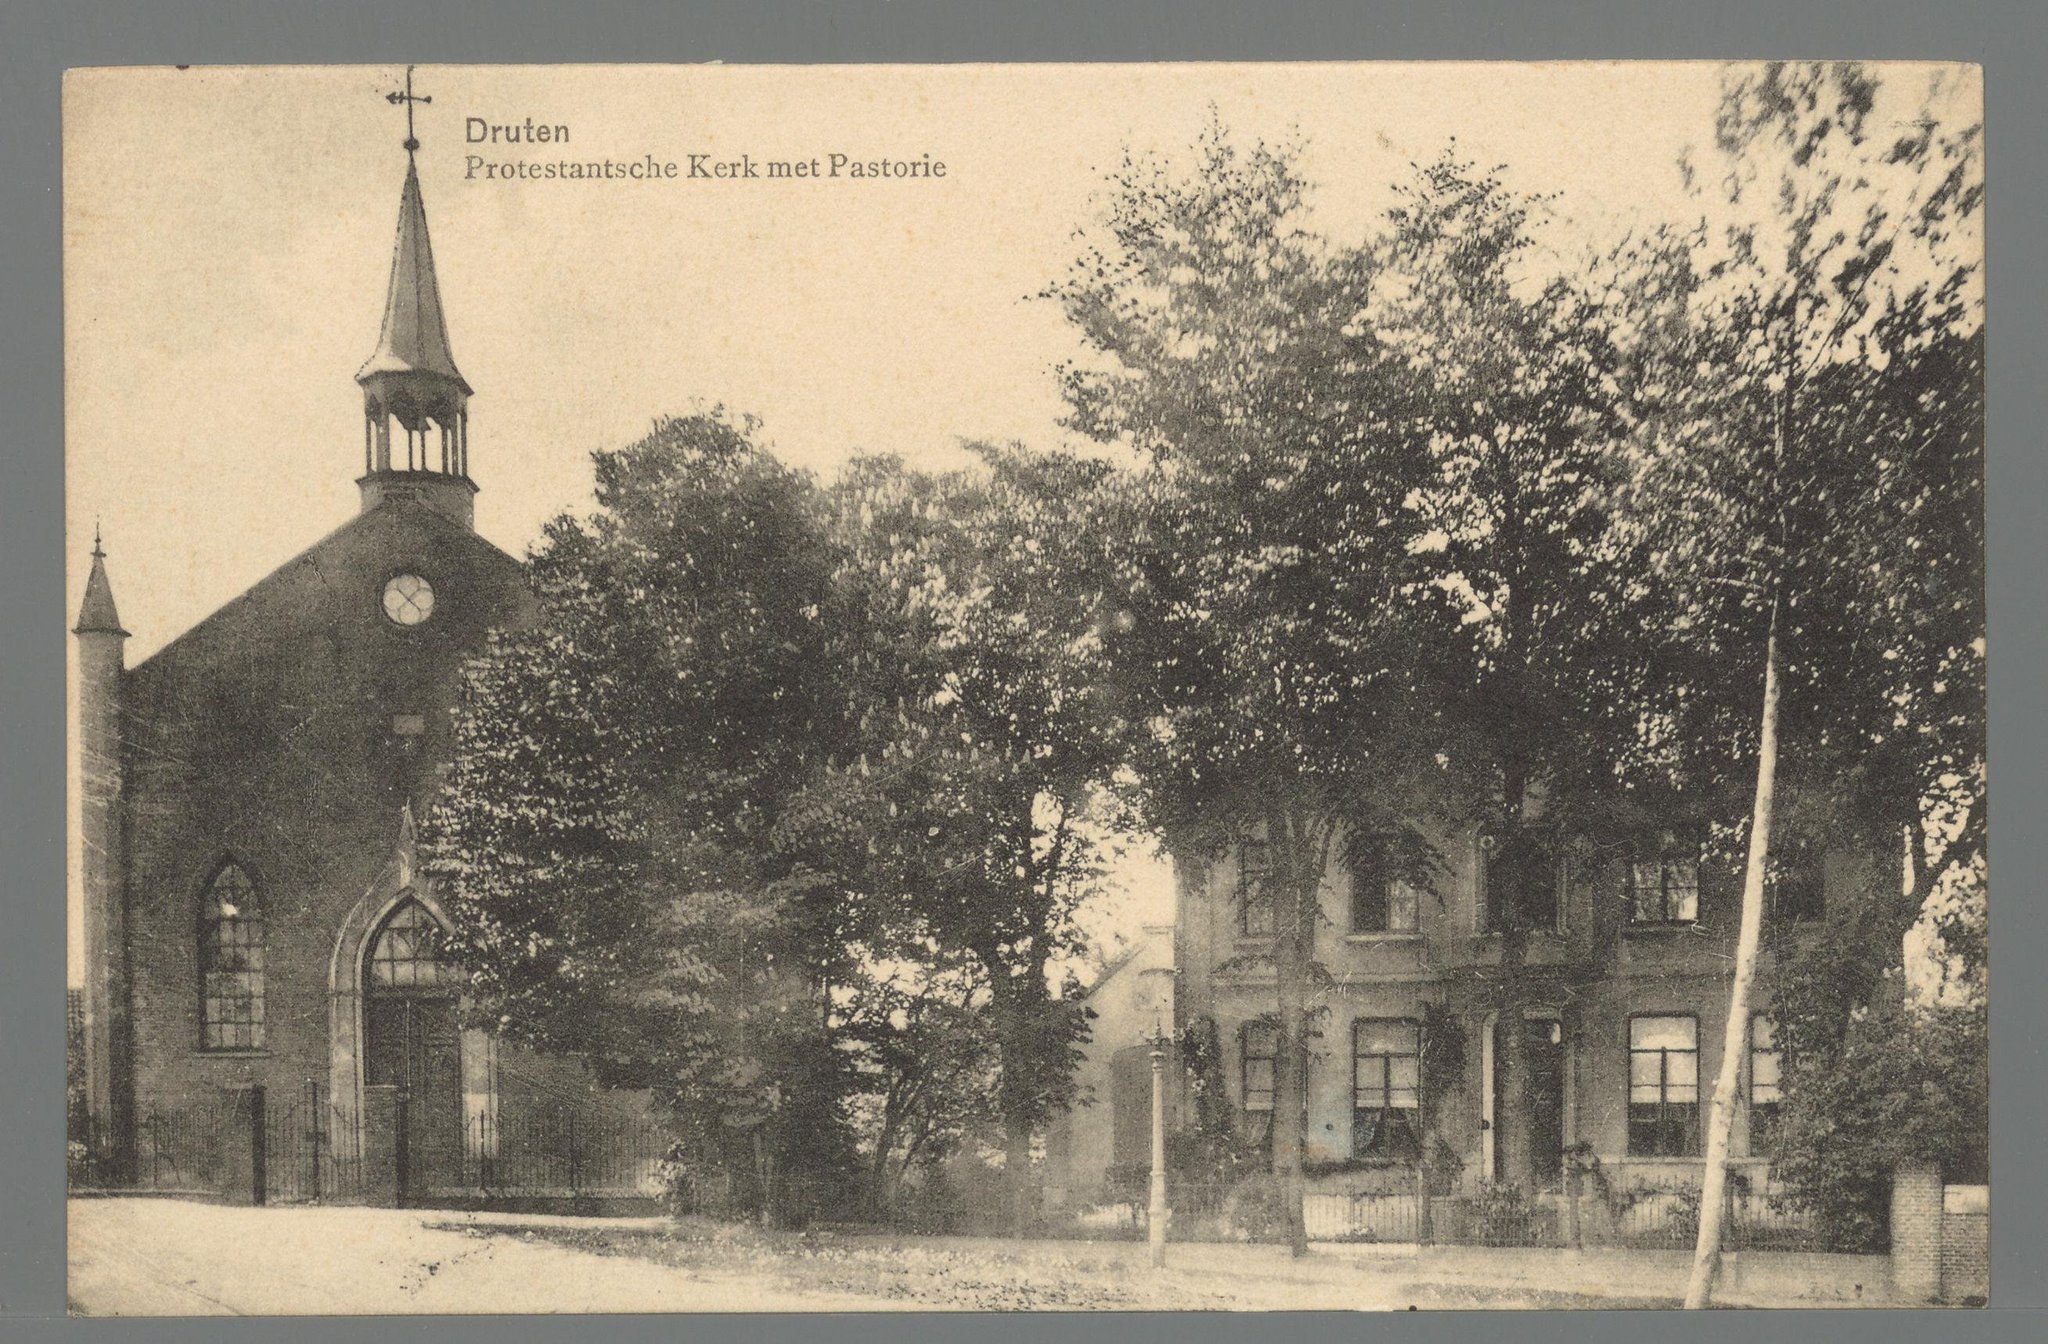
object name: ansichtkaart, prentbriefkaart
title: Druten. Protestantsche Kerk met pastorie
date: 1905-1930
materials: cardboard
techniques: photograph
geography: druten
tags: church (exterior)